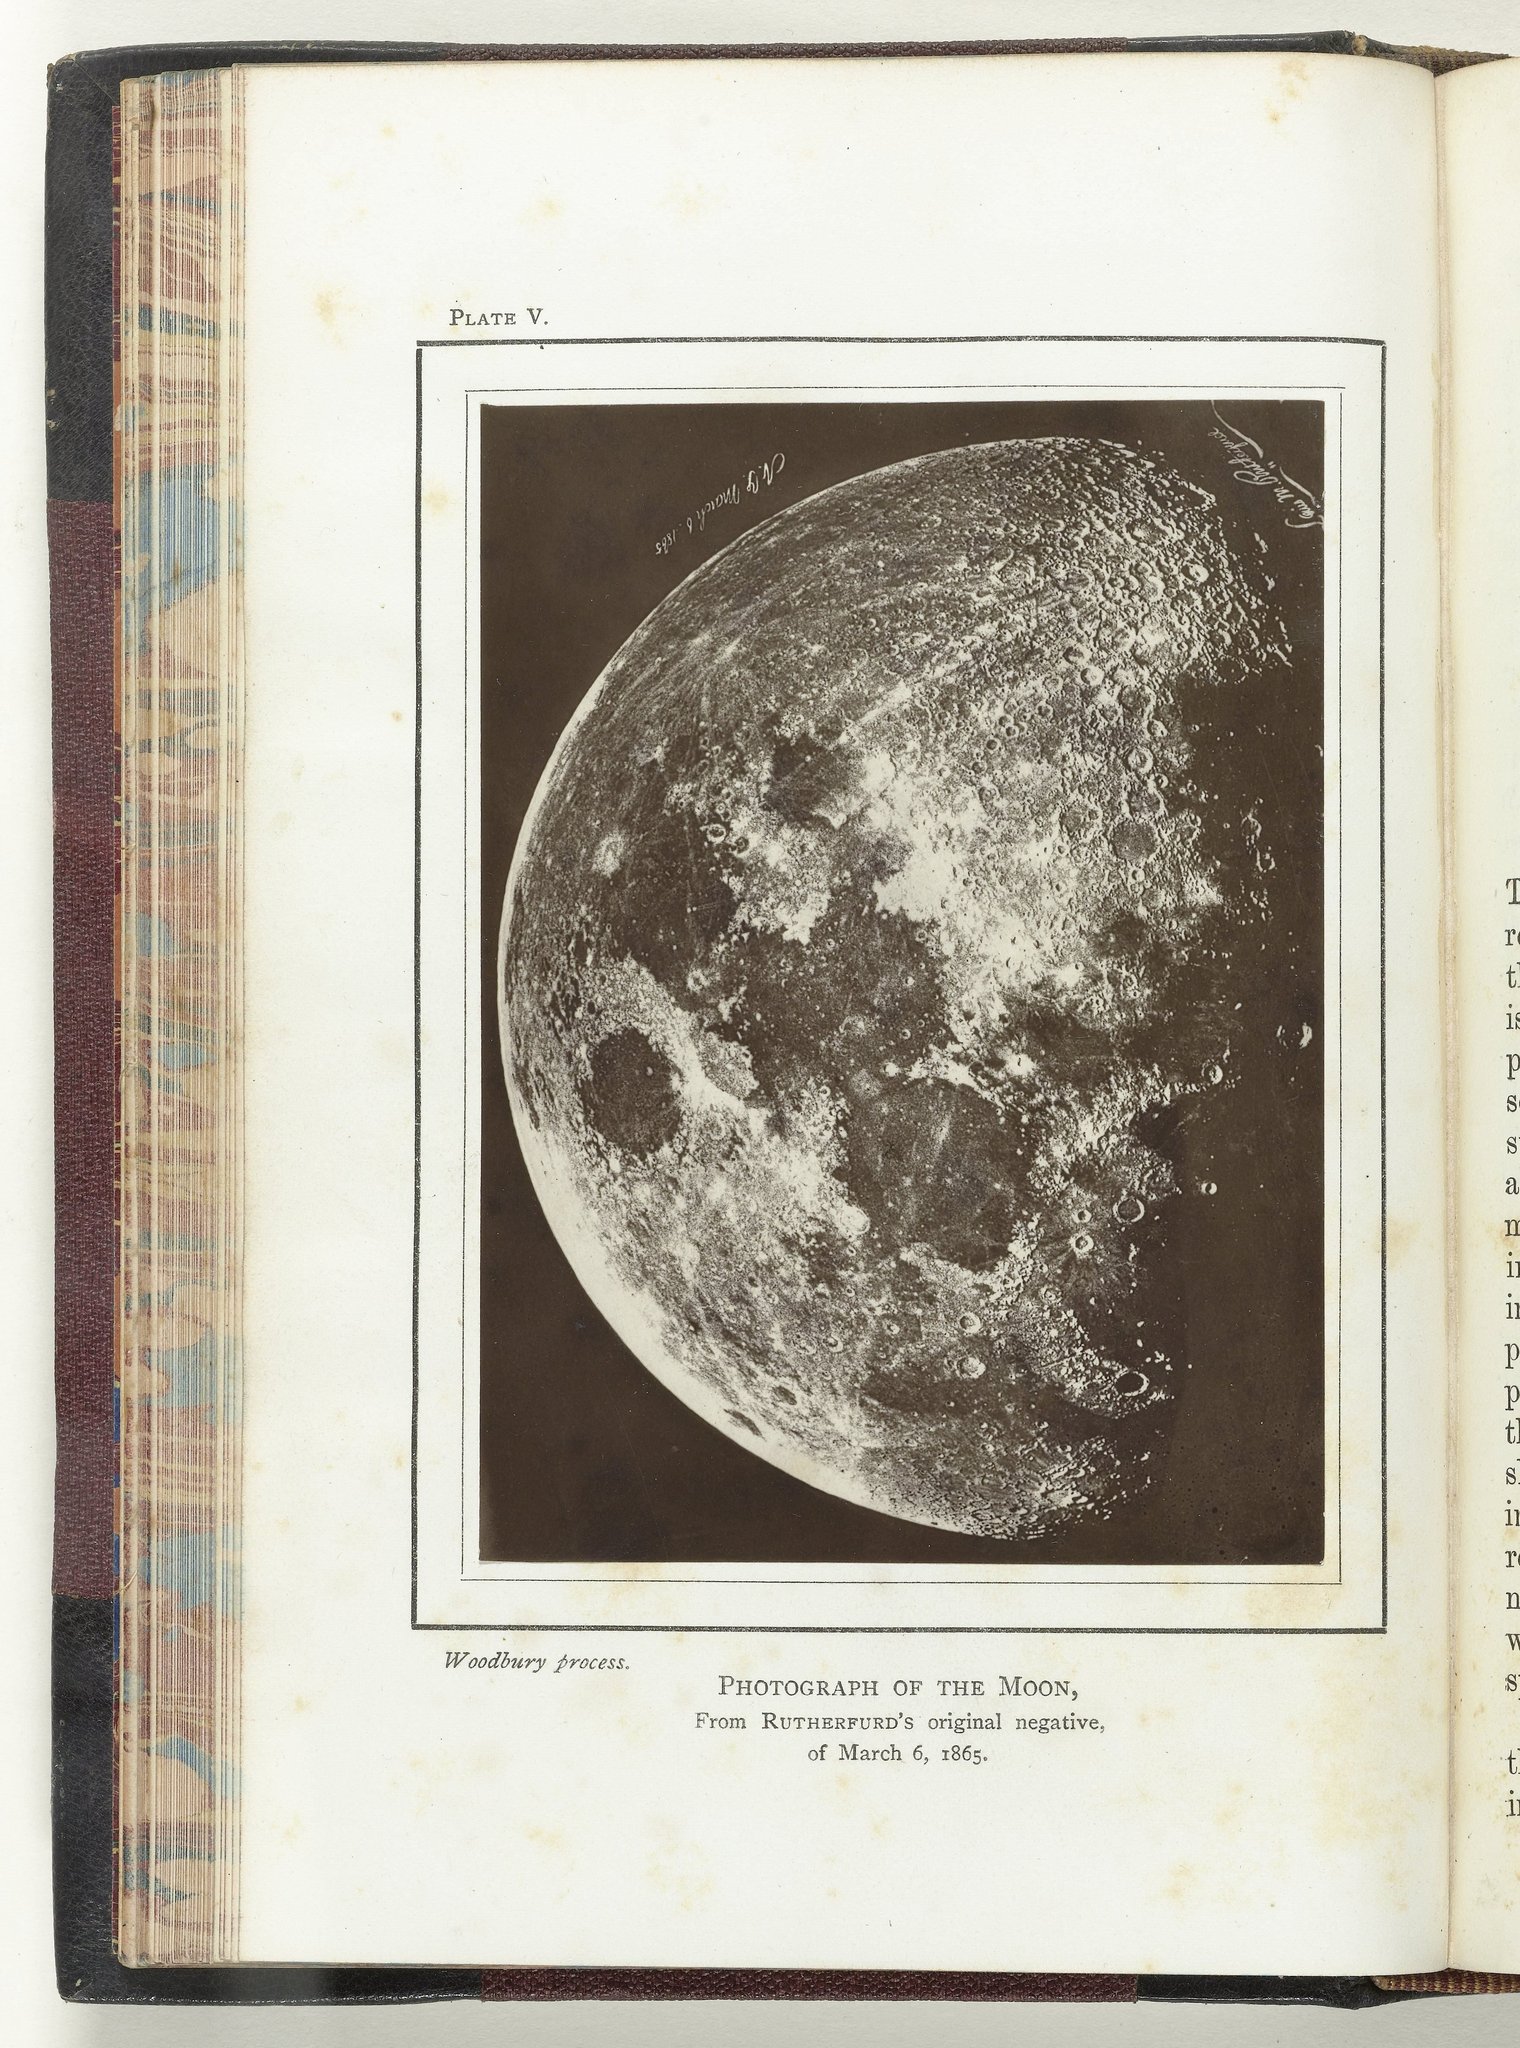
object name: reproduction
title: Fotoreproductie van een tekening, voorstellende een studie voor de wachters bij de tombe van Christus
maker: Anonymous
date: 1872-1882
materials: paper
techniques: photograph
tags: frightened and/or sleeping soldiers at the tomb of christ